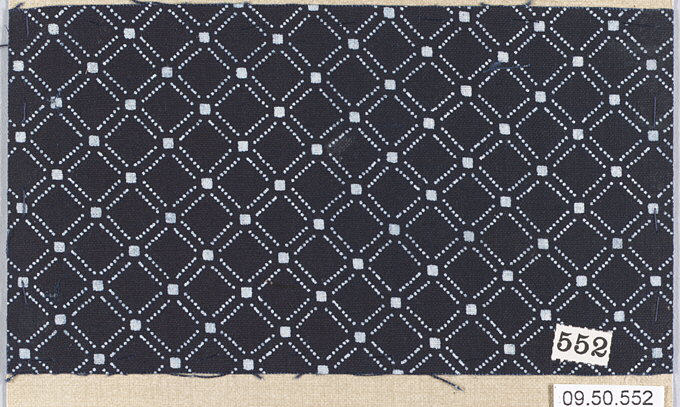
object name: piece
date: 1801-1900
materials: cotton